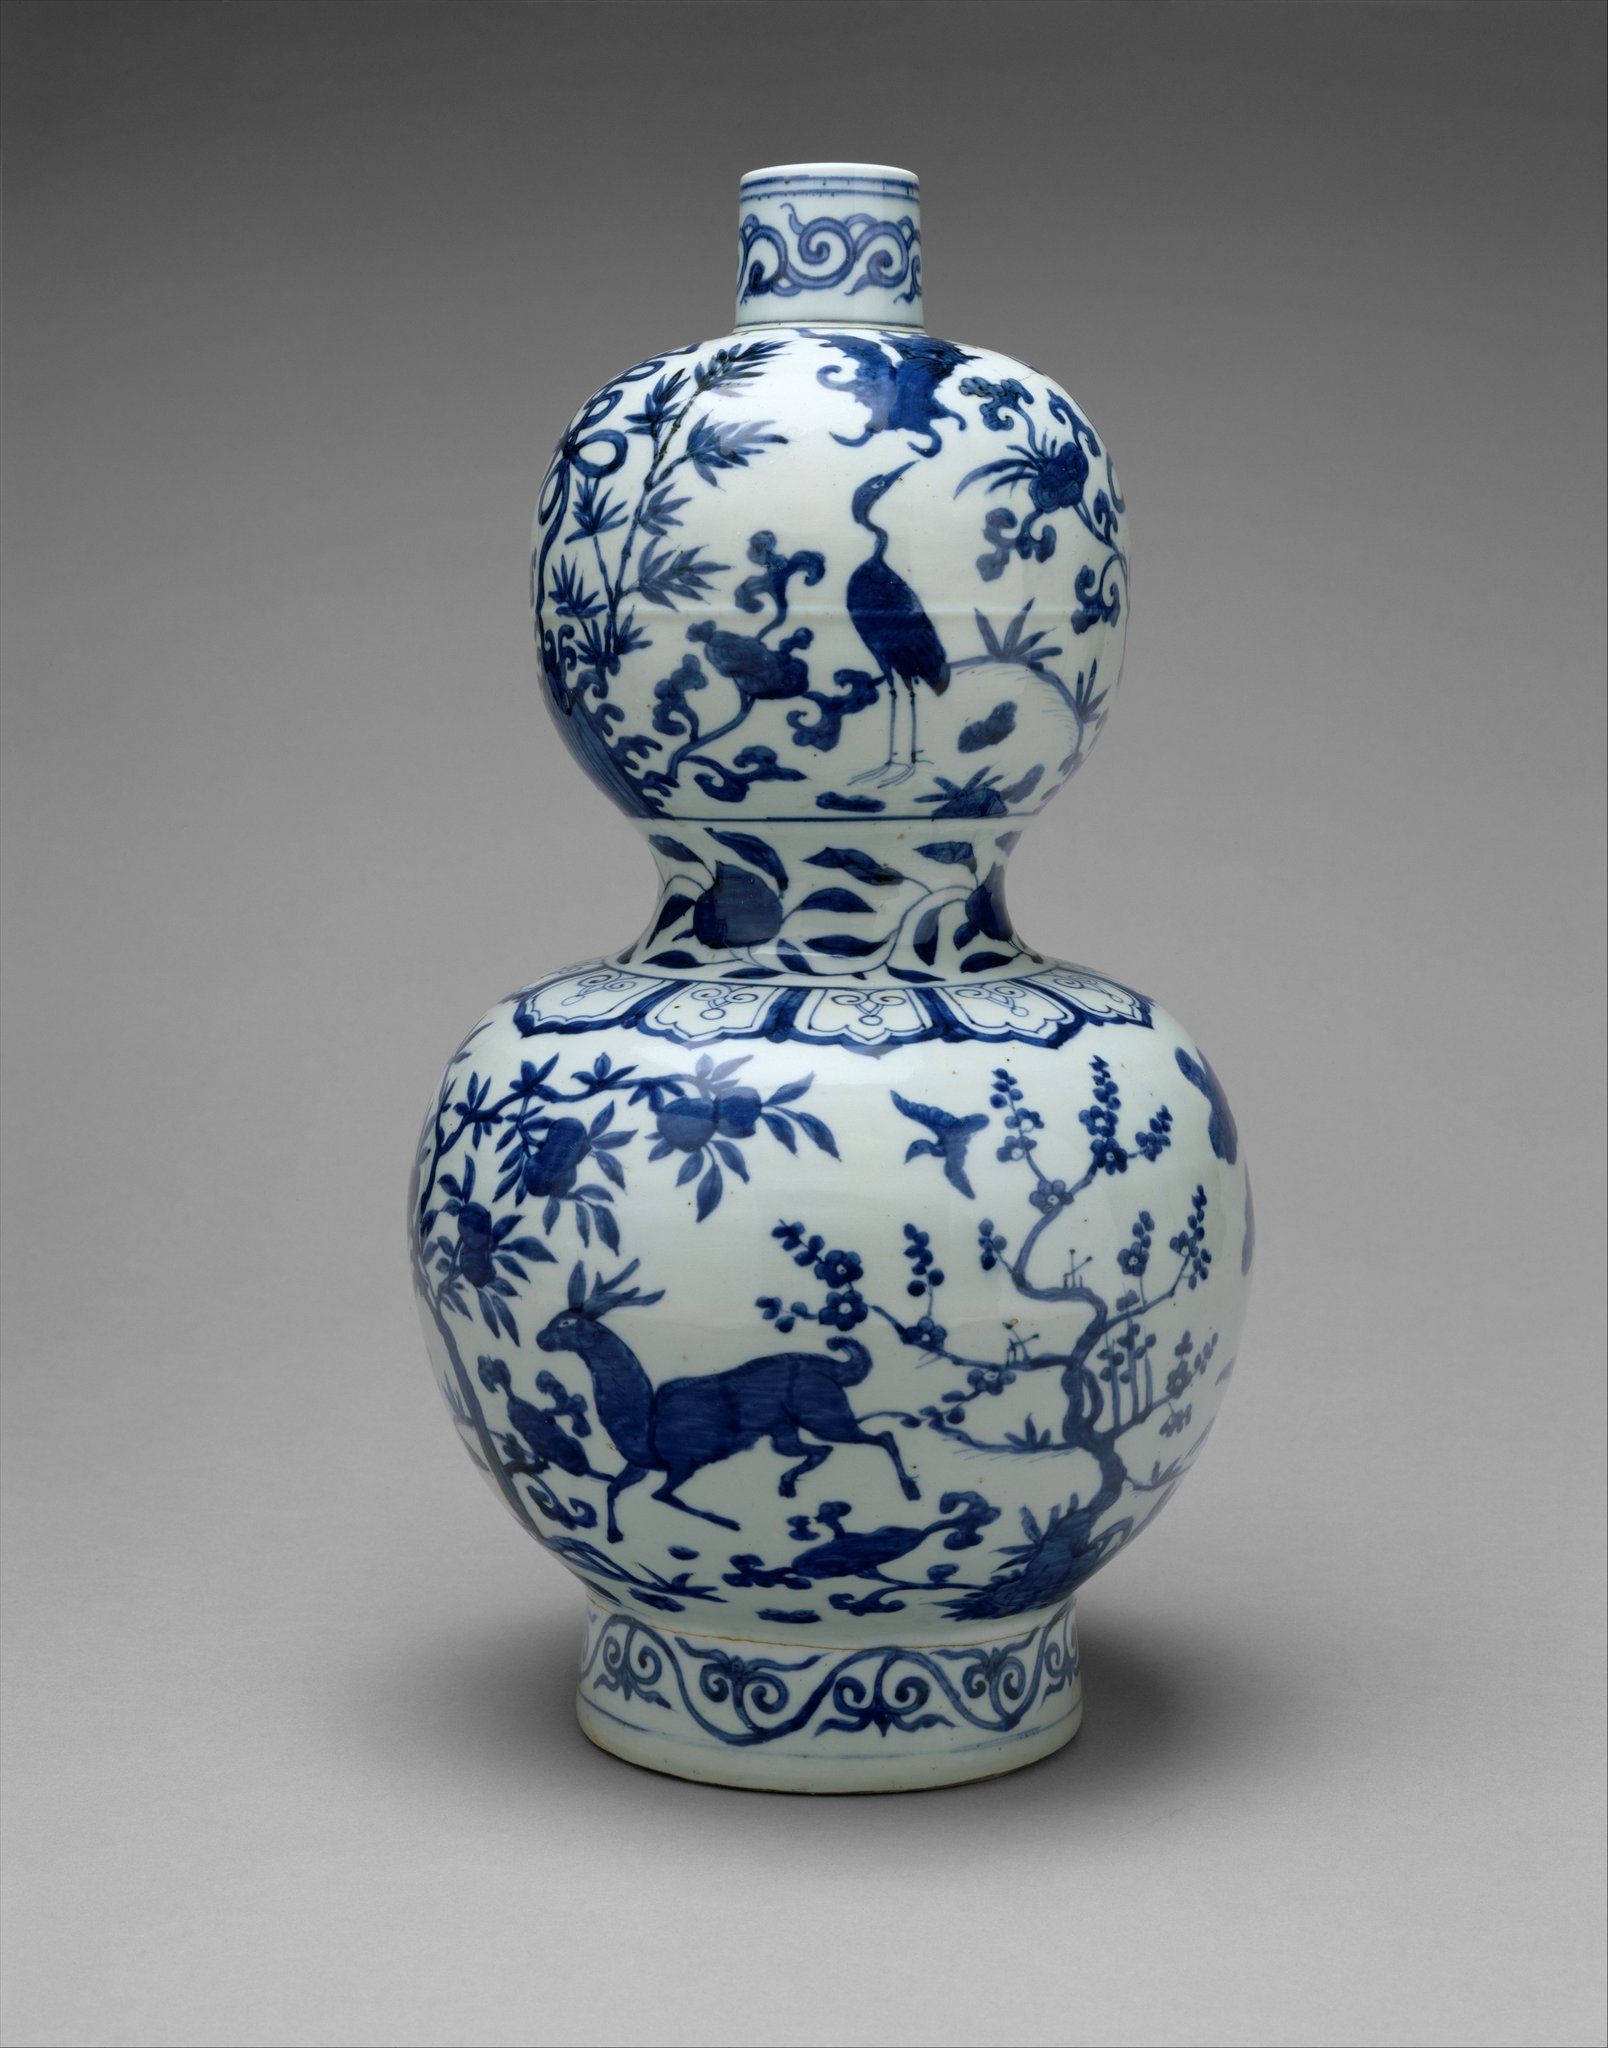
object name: bottle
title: Gourd-Shaped Bottle with Deer and Crane in Landscape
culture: chinese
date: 1534-1566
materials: cobalt, glaze, porcelain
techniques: painting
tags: cranes,deer,trees